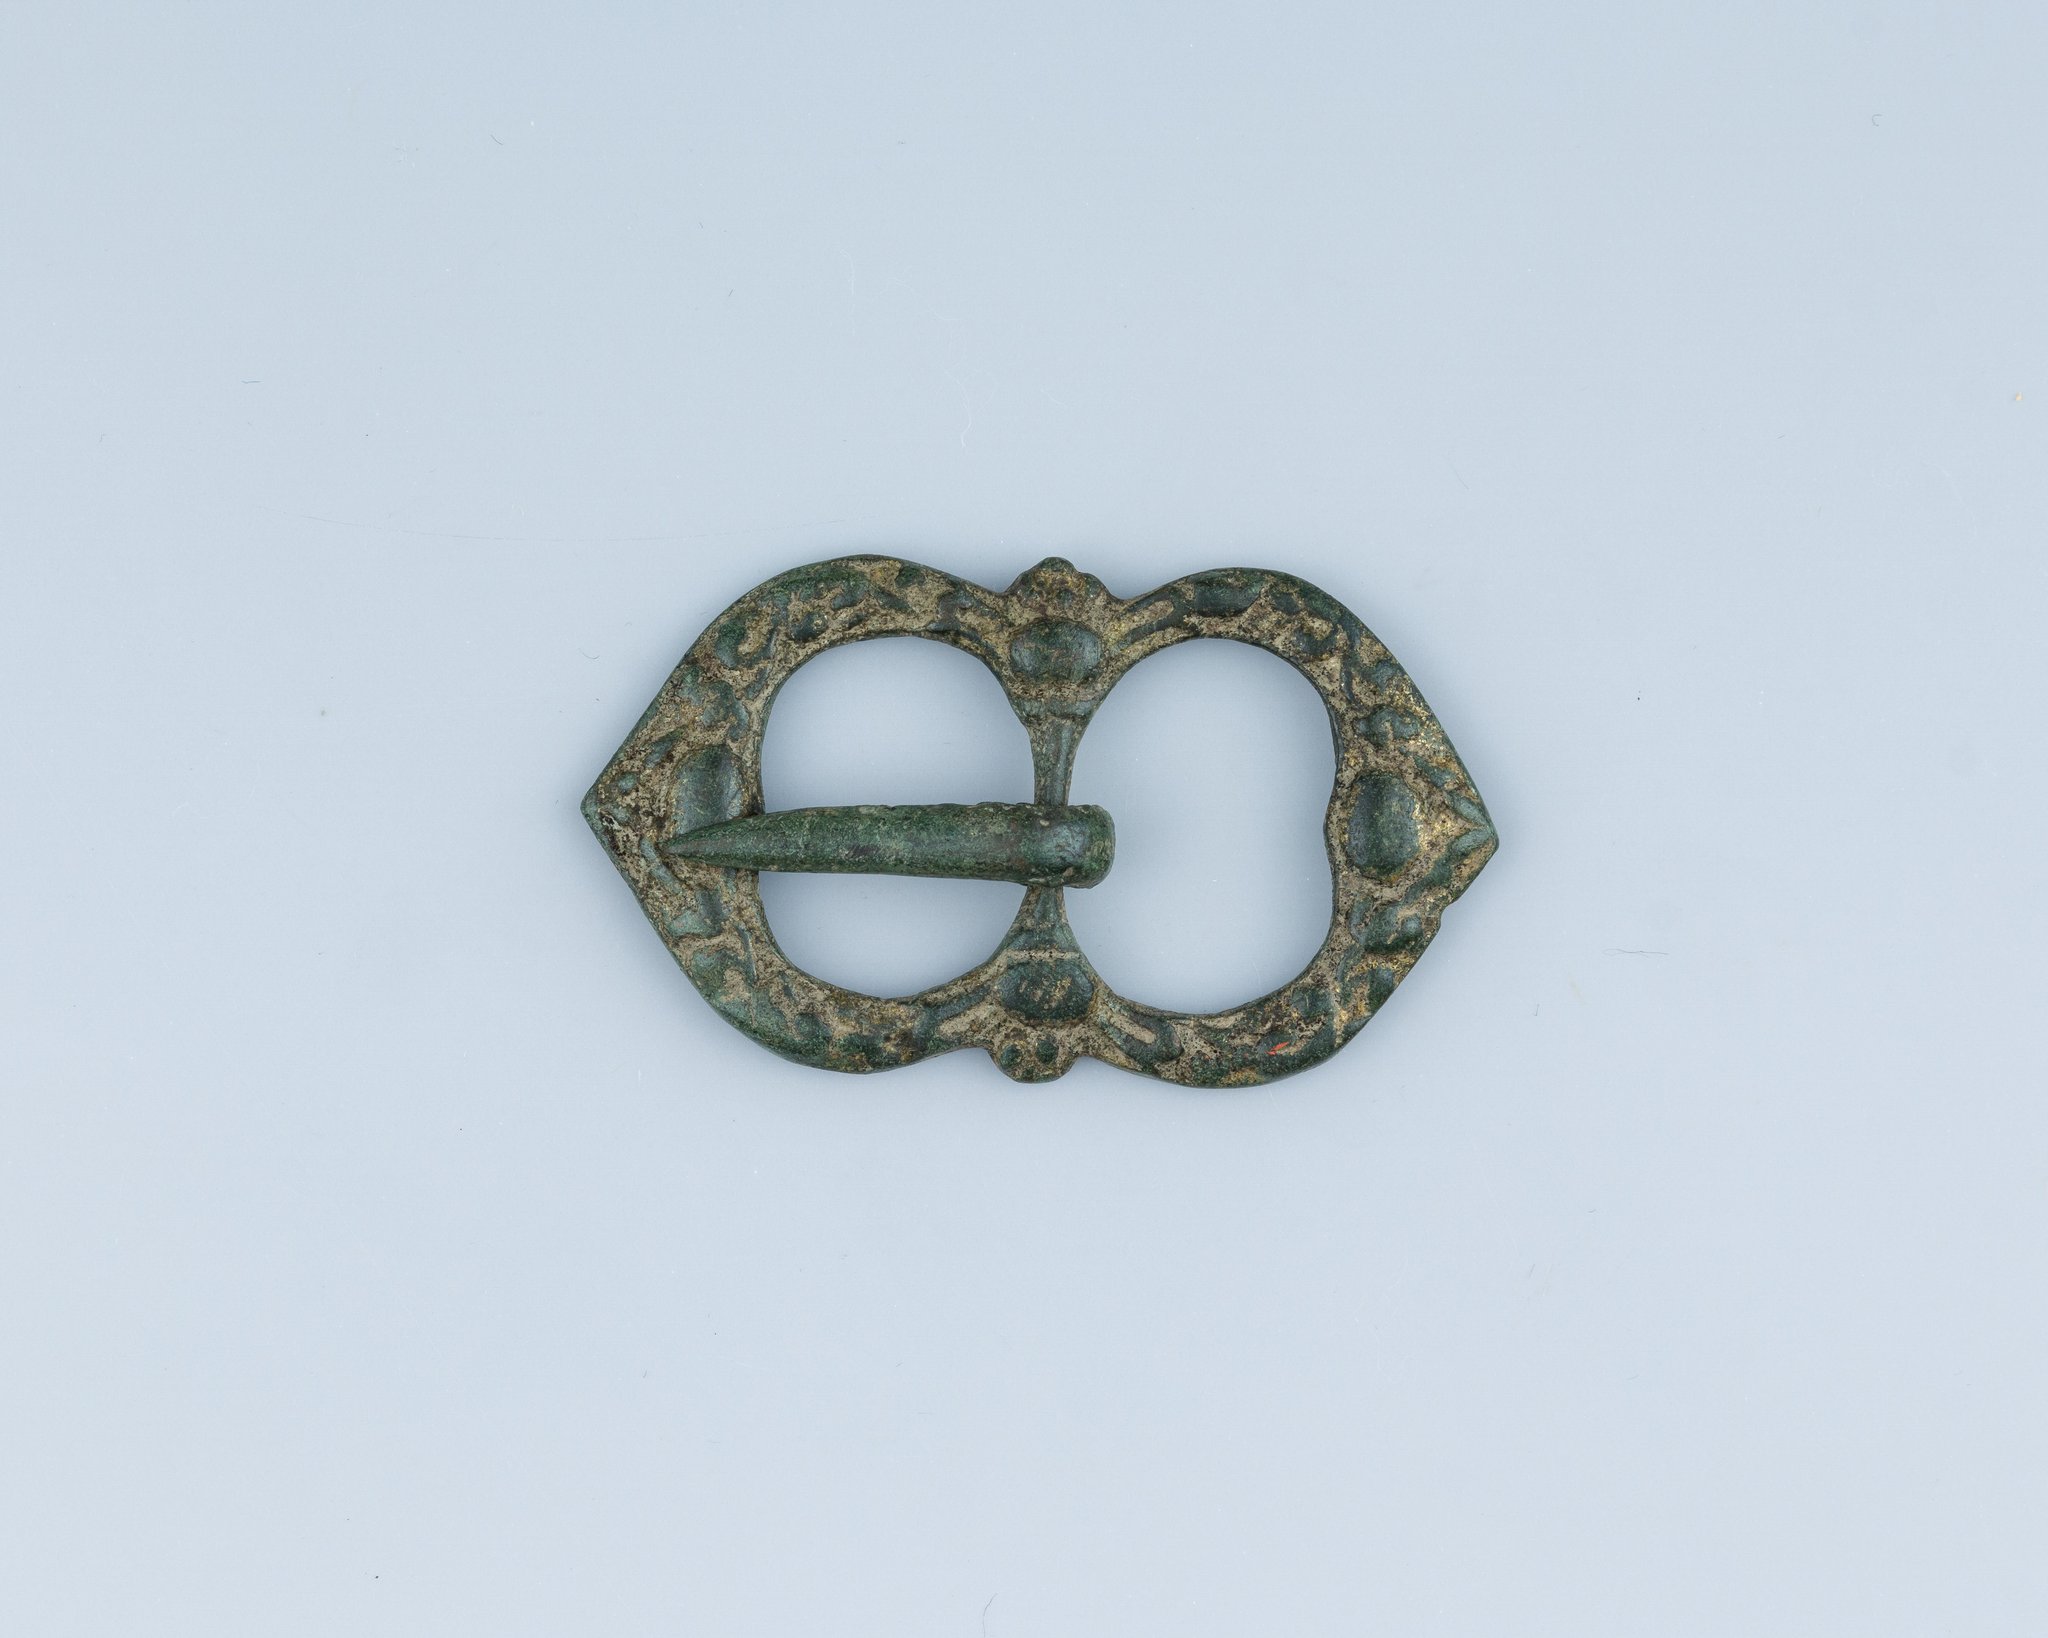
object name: buckle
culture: european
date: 1401-1600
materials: bronze, gold, patina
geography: germany